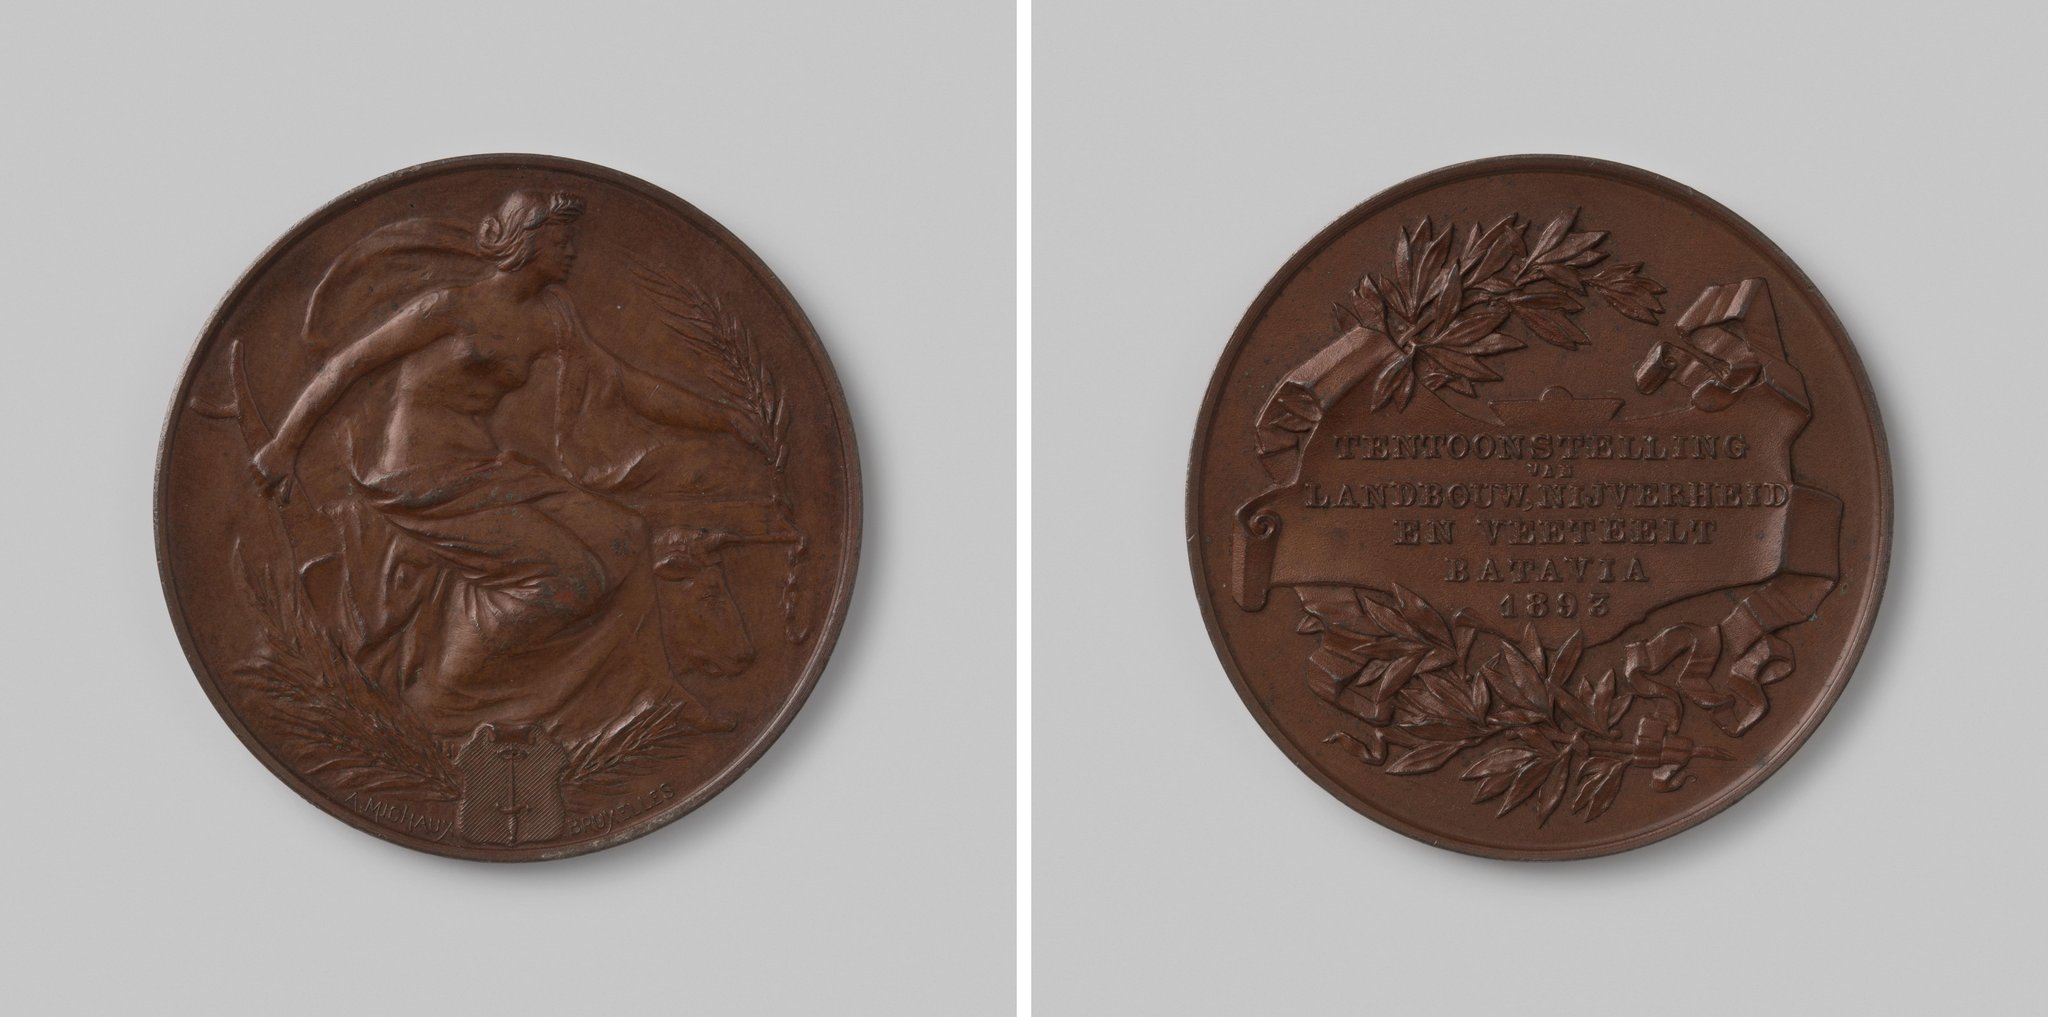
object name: history medal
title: Tentoonstelling van landbouw, nijverheid en veeteelt te Batavia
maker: alphonse michaux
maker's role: medailleur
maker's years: 1860-1928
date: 1893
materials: bronze, paper, textile, velvet, wood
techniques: striking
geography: brussels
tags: batavia